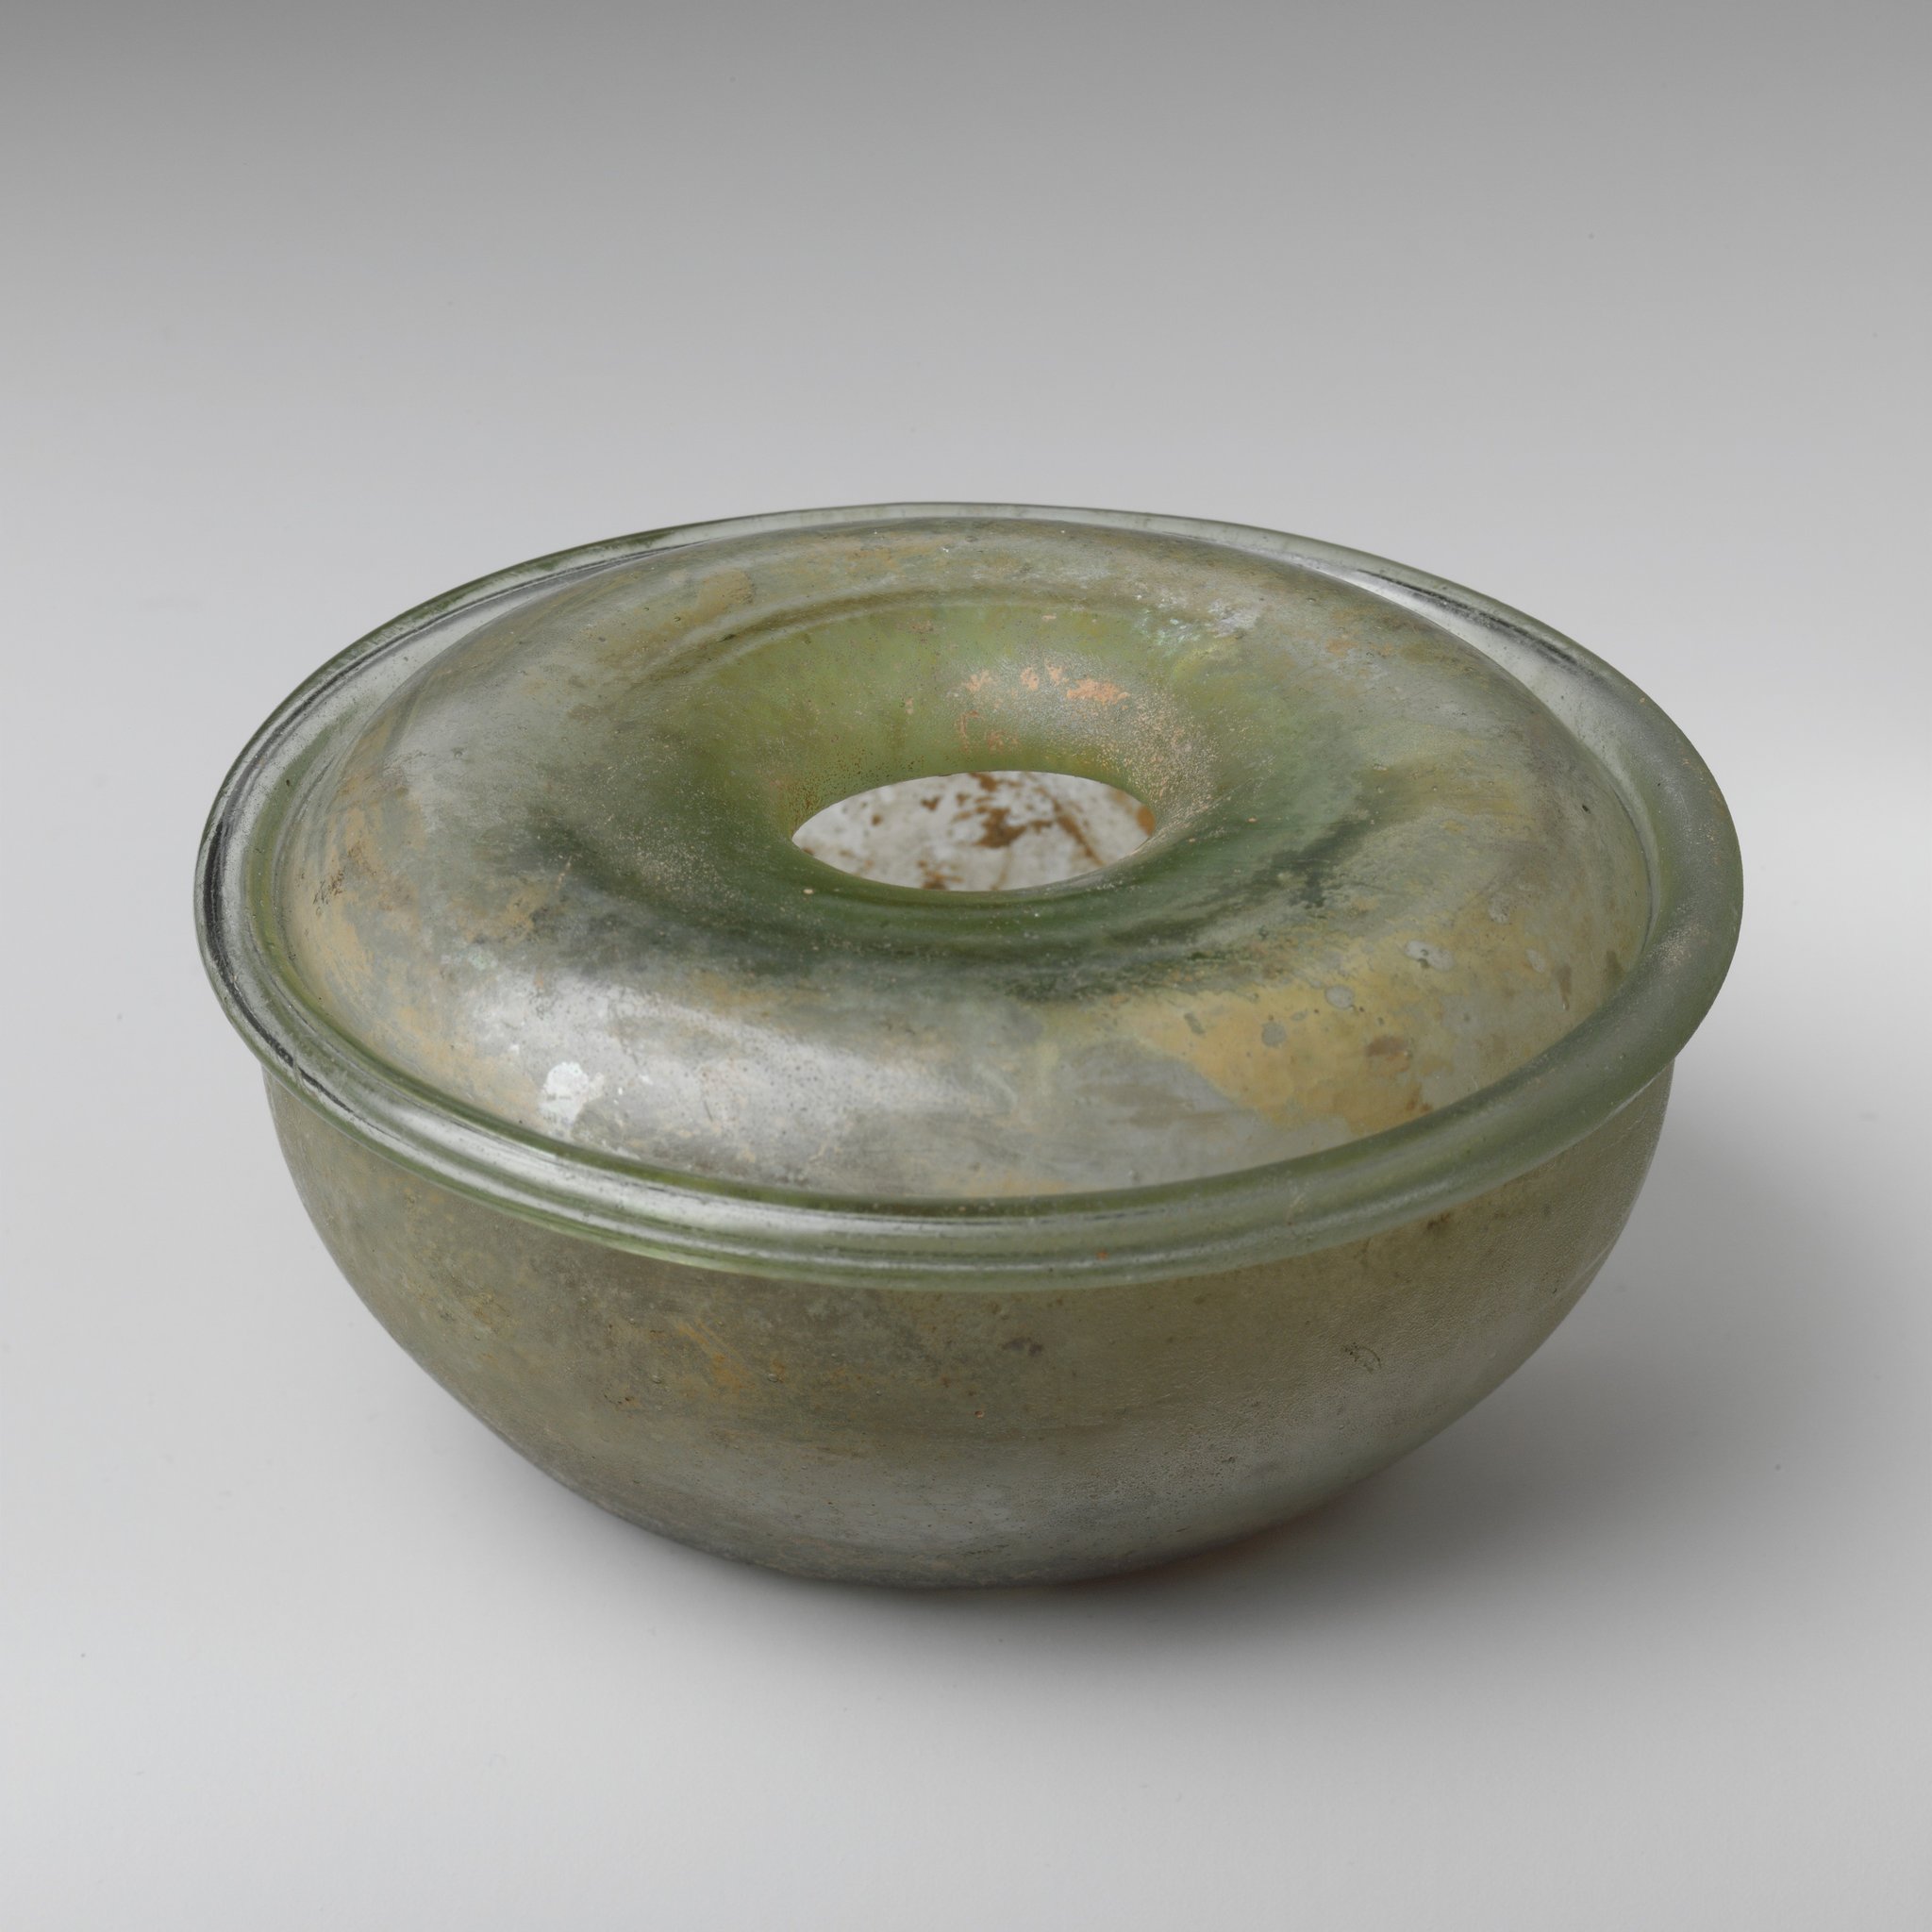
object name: inkwell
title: Glass inkwell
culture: roman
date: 1-200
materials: glass